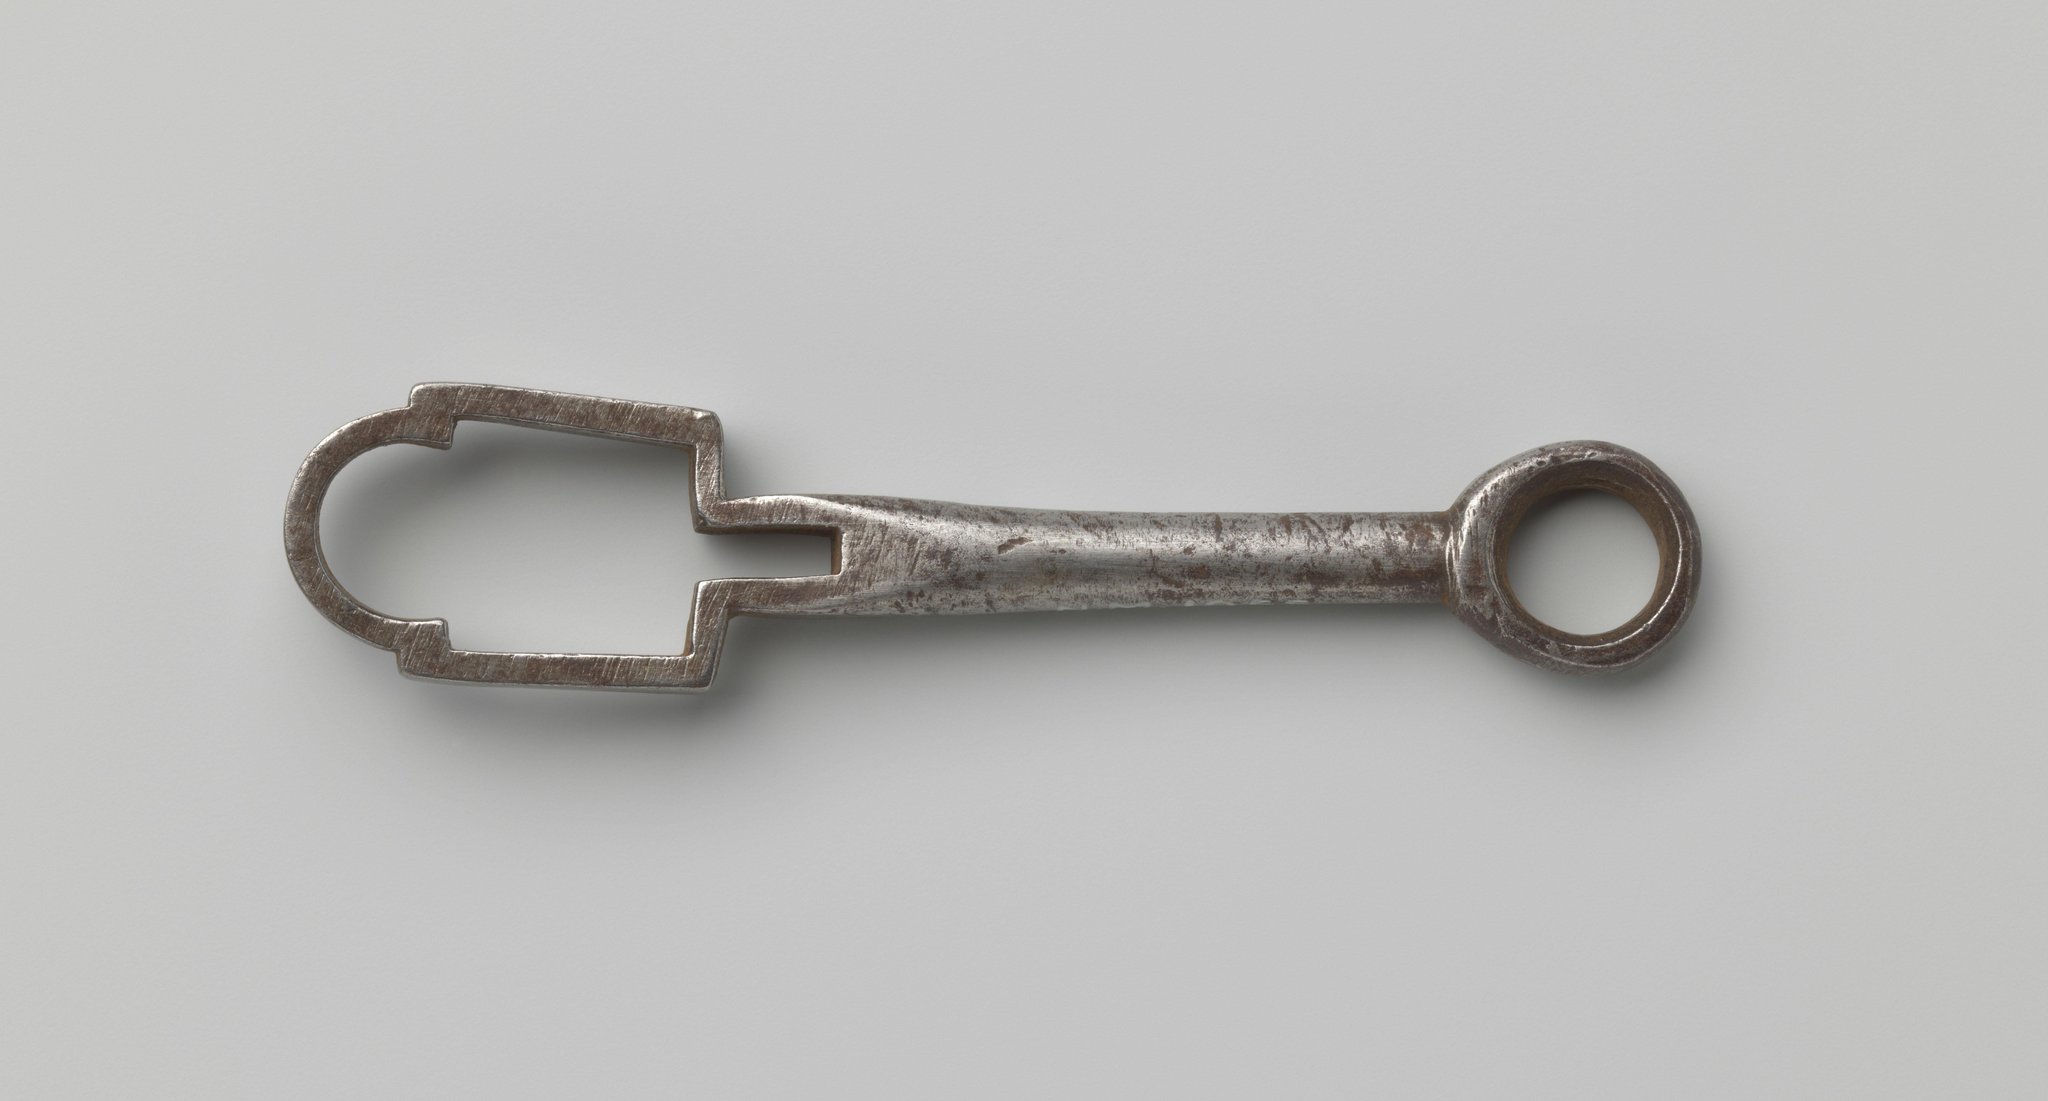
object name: key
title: Sleutel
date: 1400-1950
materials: iron